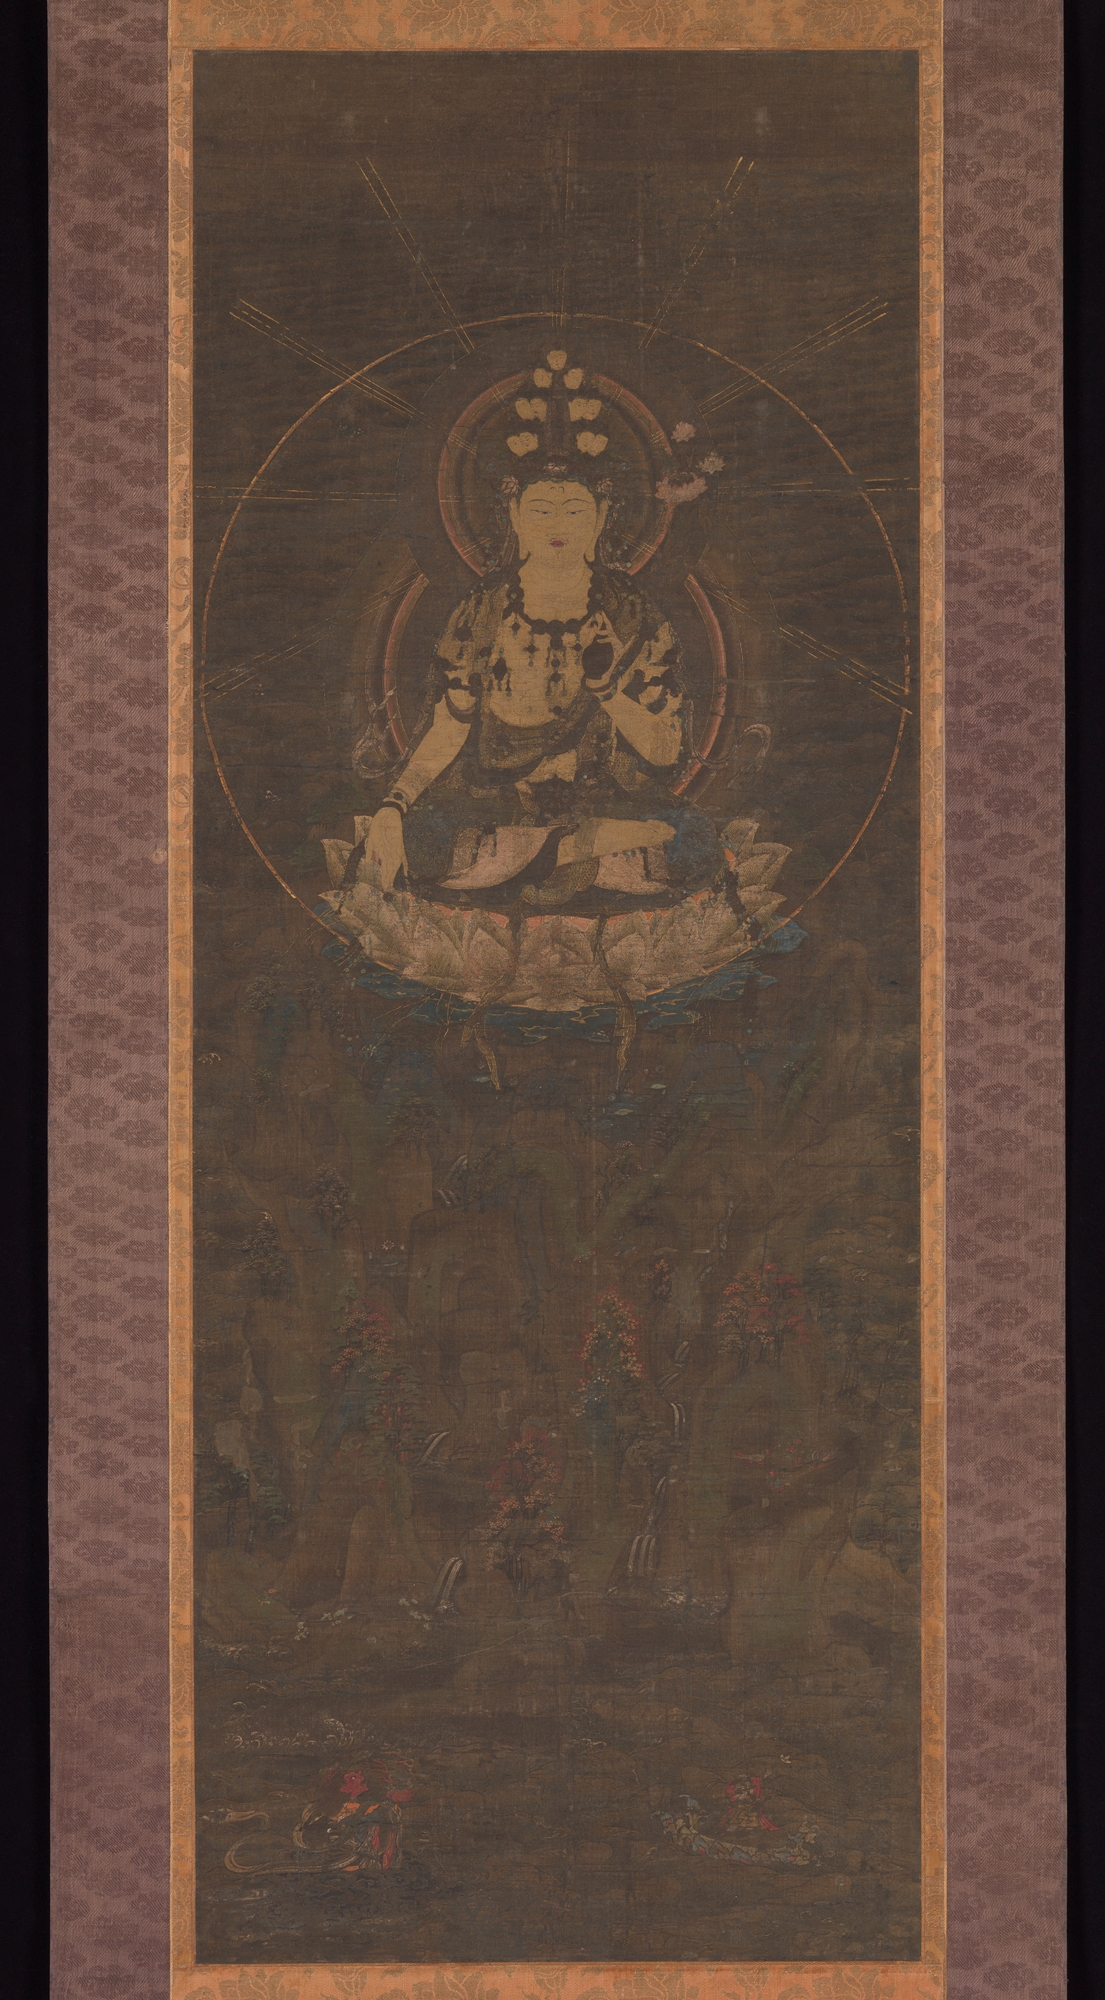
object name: hanging scroll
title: Eleven-Headed Kannon on Mount Fudaraku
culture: japanese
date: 1201-1300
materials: gold, ink, silk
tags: bodhisattvas